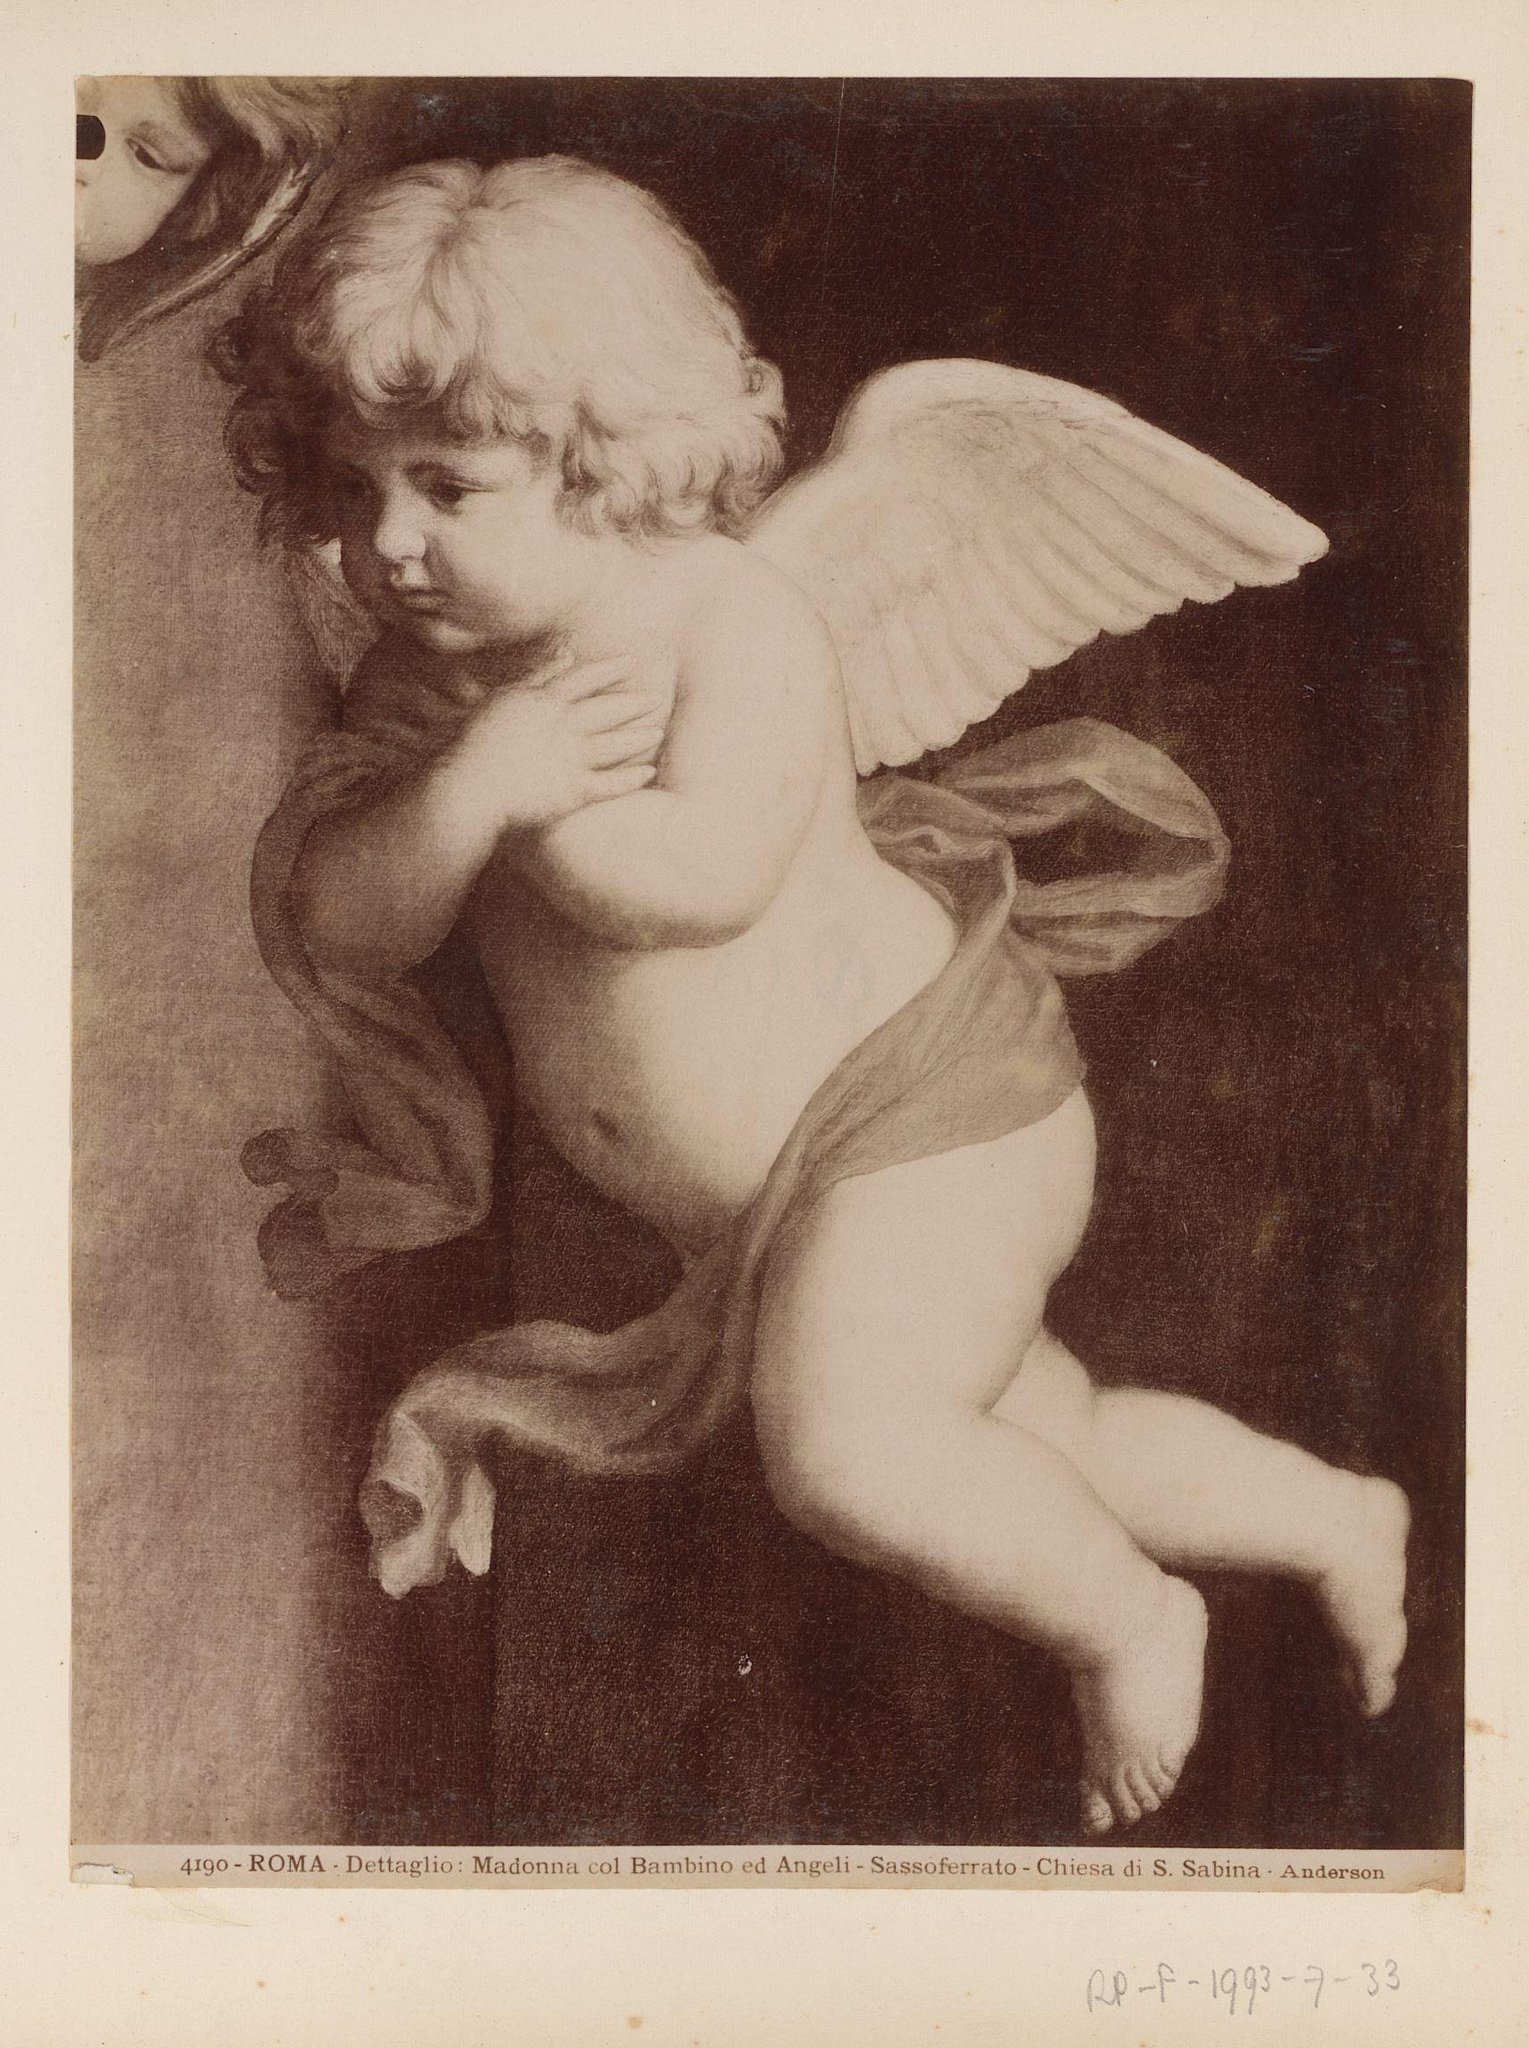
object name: album leaf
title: Fotoreproductie van detail van schilderij Madonna del Rosario door Sassoferrato in de Santa Sabina te Rome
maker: james anderson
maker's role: fotograaf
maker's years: 1813-1877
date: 1857-1875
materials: paper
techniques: albumen print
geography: santa sabina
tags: picture, painting, cupids: 'amores', 'amoretti', 'putti'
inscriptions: inscription: ‘4190 - ROMA - Dettaglio: Madonna col Bambino ed Angeli - Sassoferrato - Chiesa di S. Sabina - Anderson’